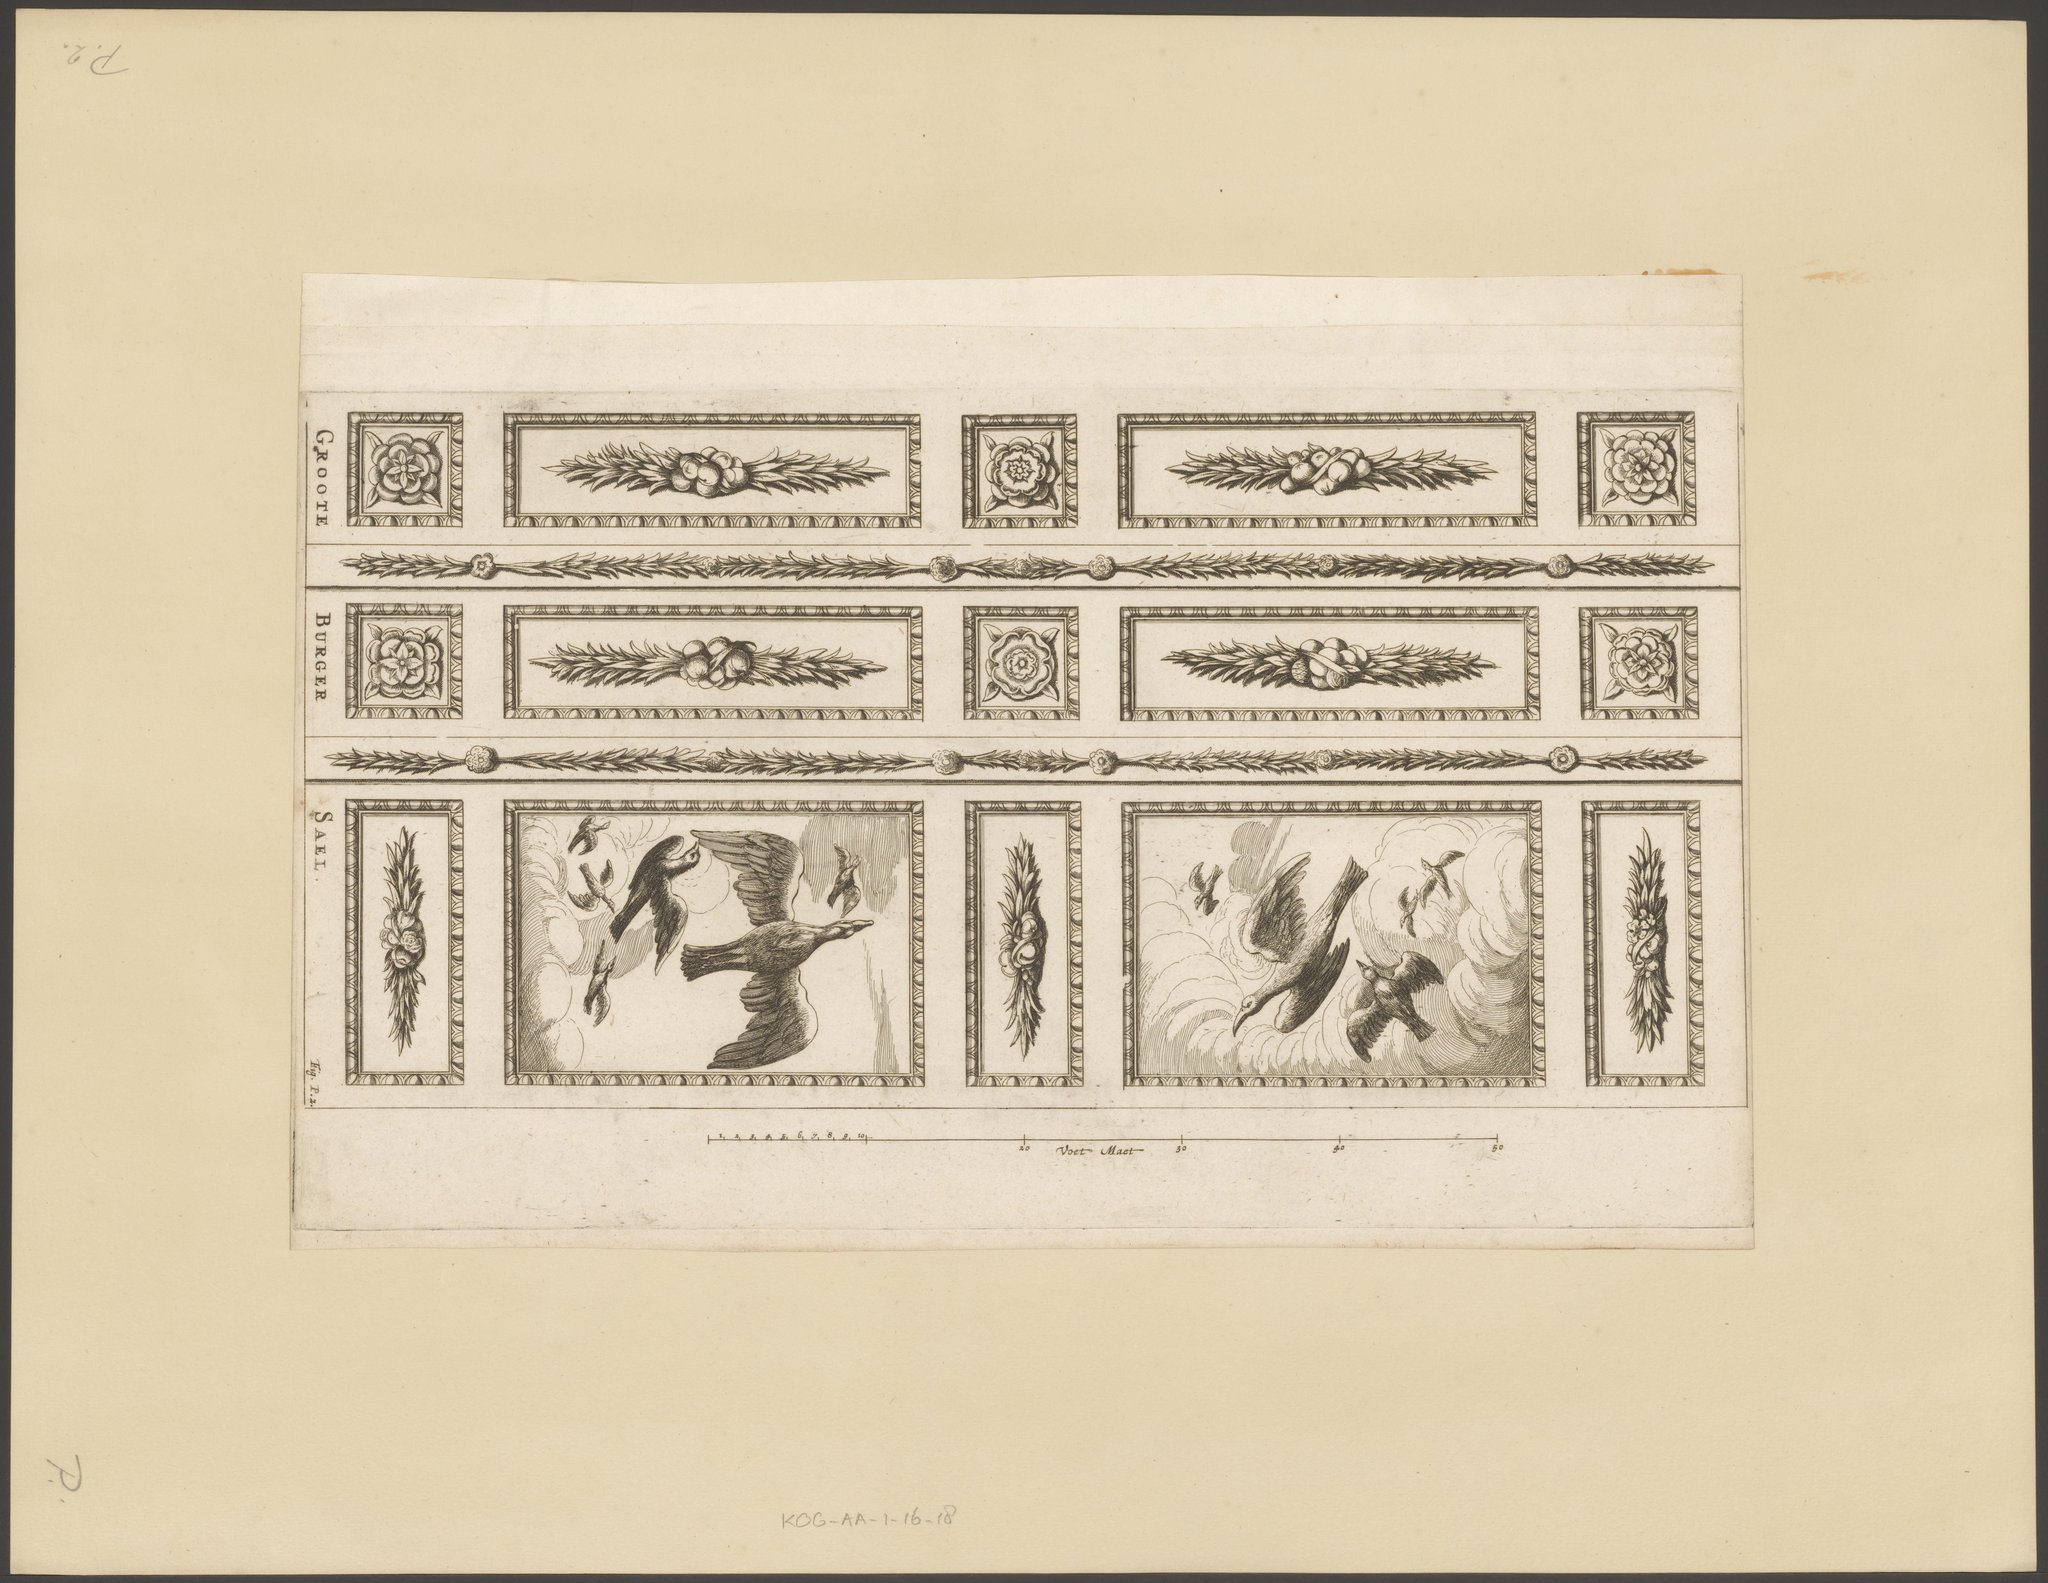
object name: print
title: Plafond van de Burgerzaal in het Stadhuis op de Dam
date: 1661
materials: paper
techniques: engraving, etching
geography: amsterdam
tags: interior ~ architectural design or model, townhall, (decorated) ceiling, plan ~ architecture, fall of phaethon; he is struck by a thunderbolt of jupiter, star-chart, star map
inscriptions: collector's mark: ‘16,18’ Lugt 1641b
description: Onderwerpsrubriek binnen de Atlas Amsterdam: Stadhuis op de Dam. Rechtsonder: Fig. P. 2.